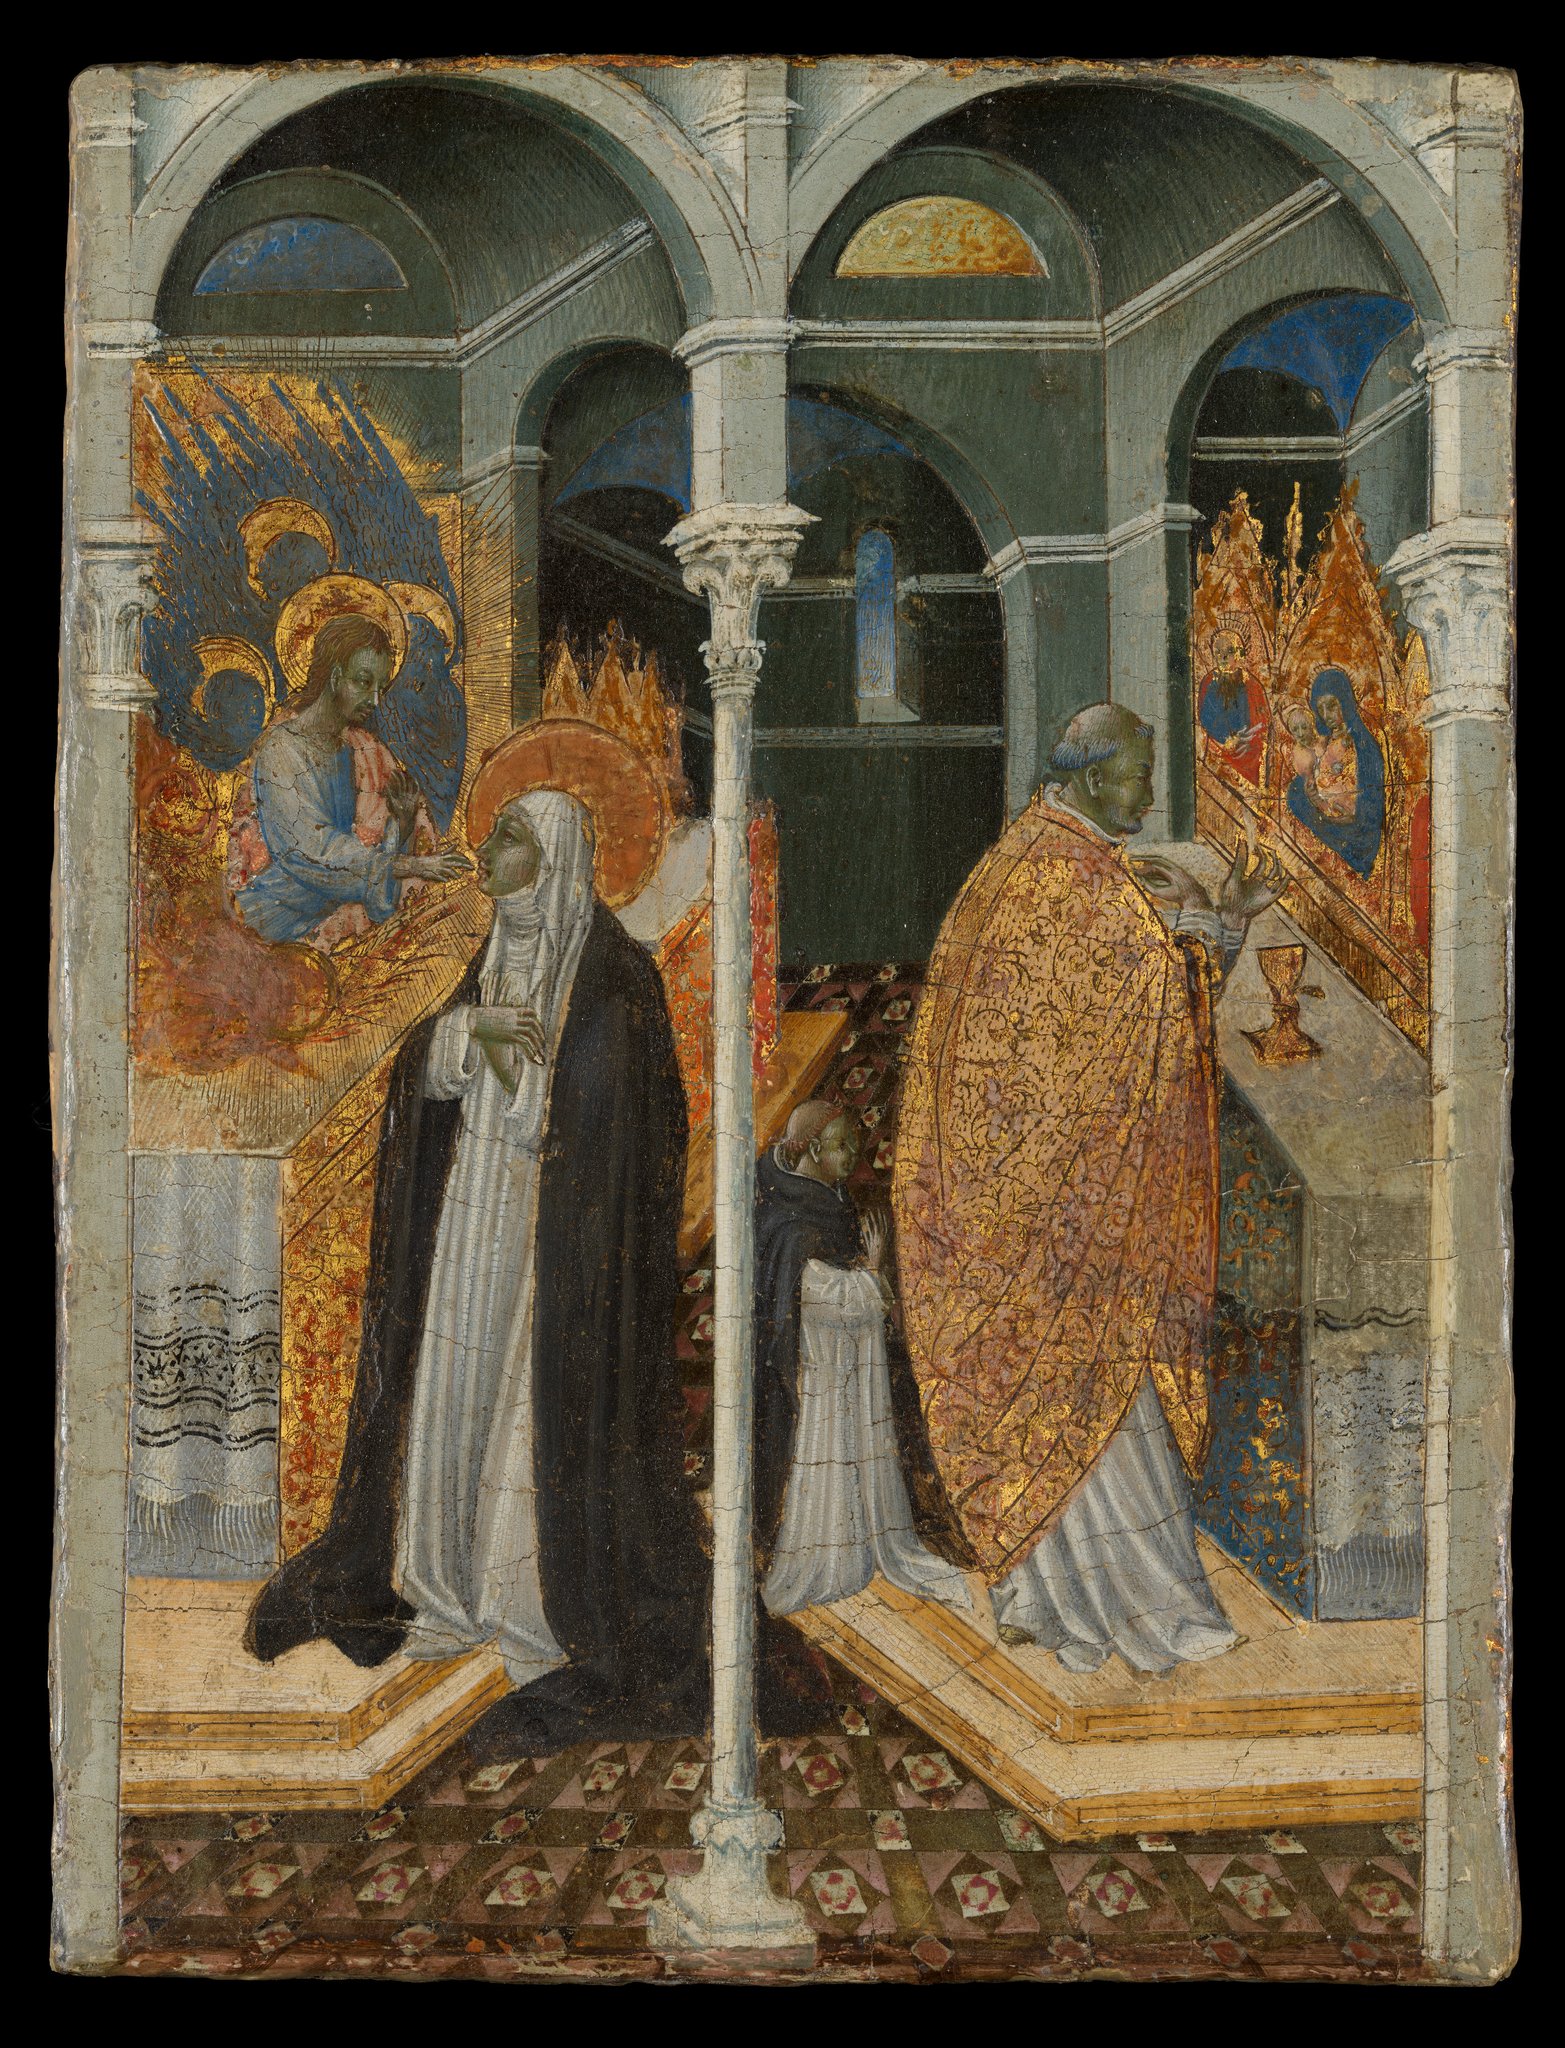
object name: painting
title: The Miraculous Communion of Saint Catherine of Siena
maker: giovanni di paolo (giovanni di paolo di grazia)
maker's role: artist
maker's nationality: italian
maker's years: 1398-1482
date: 1417-1482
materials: gold, paint, wood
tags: angels,christ,saint catherine